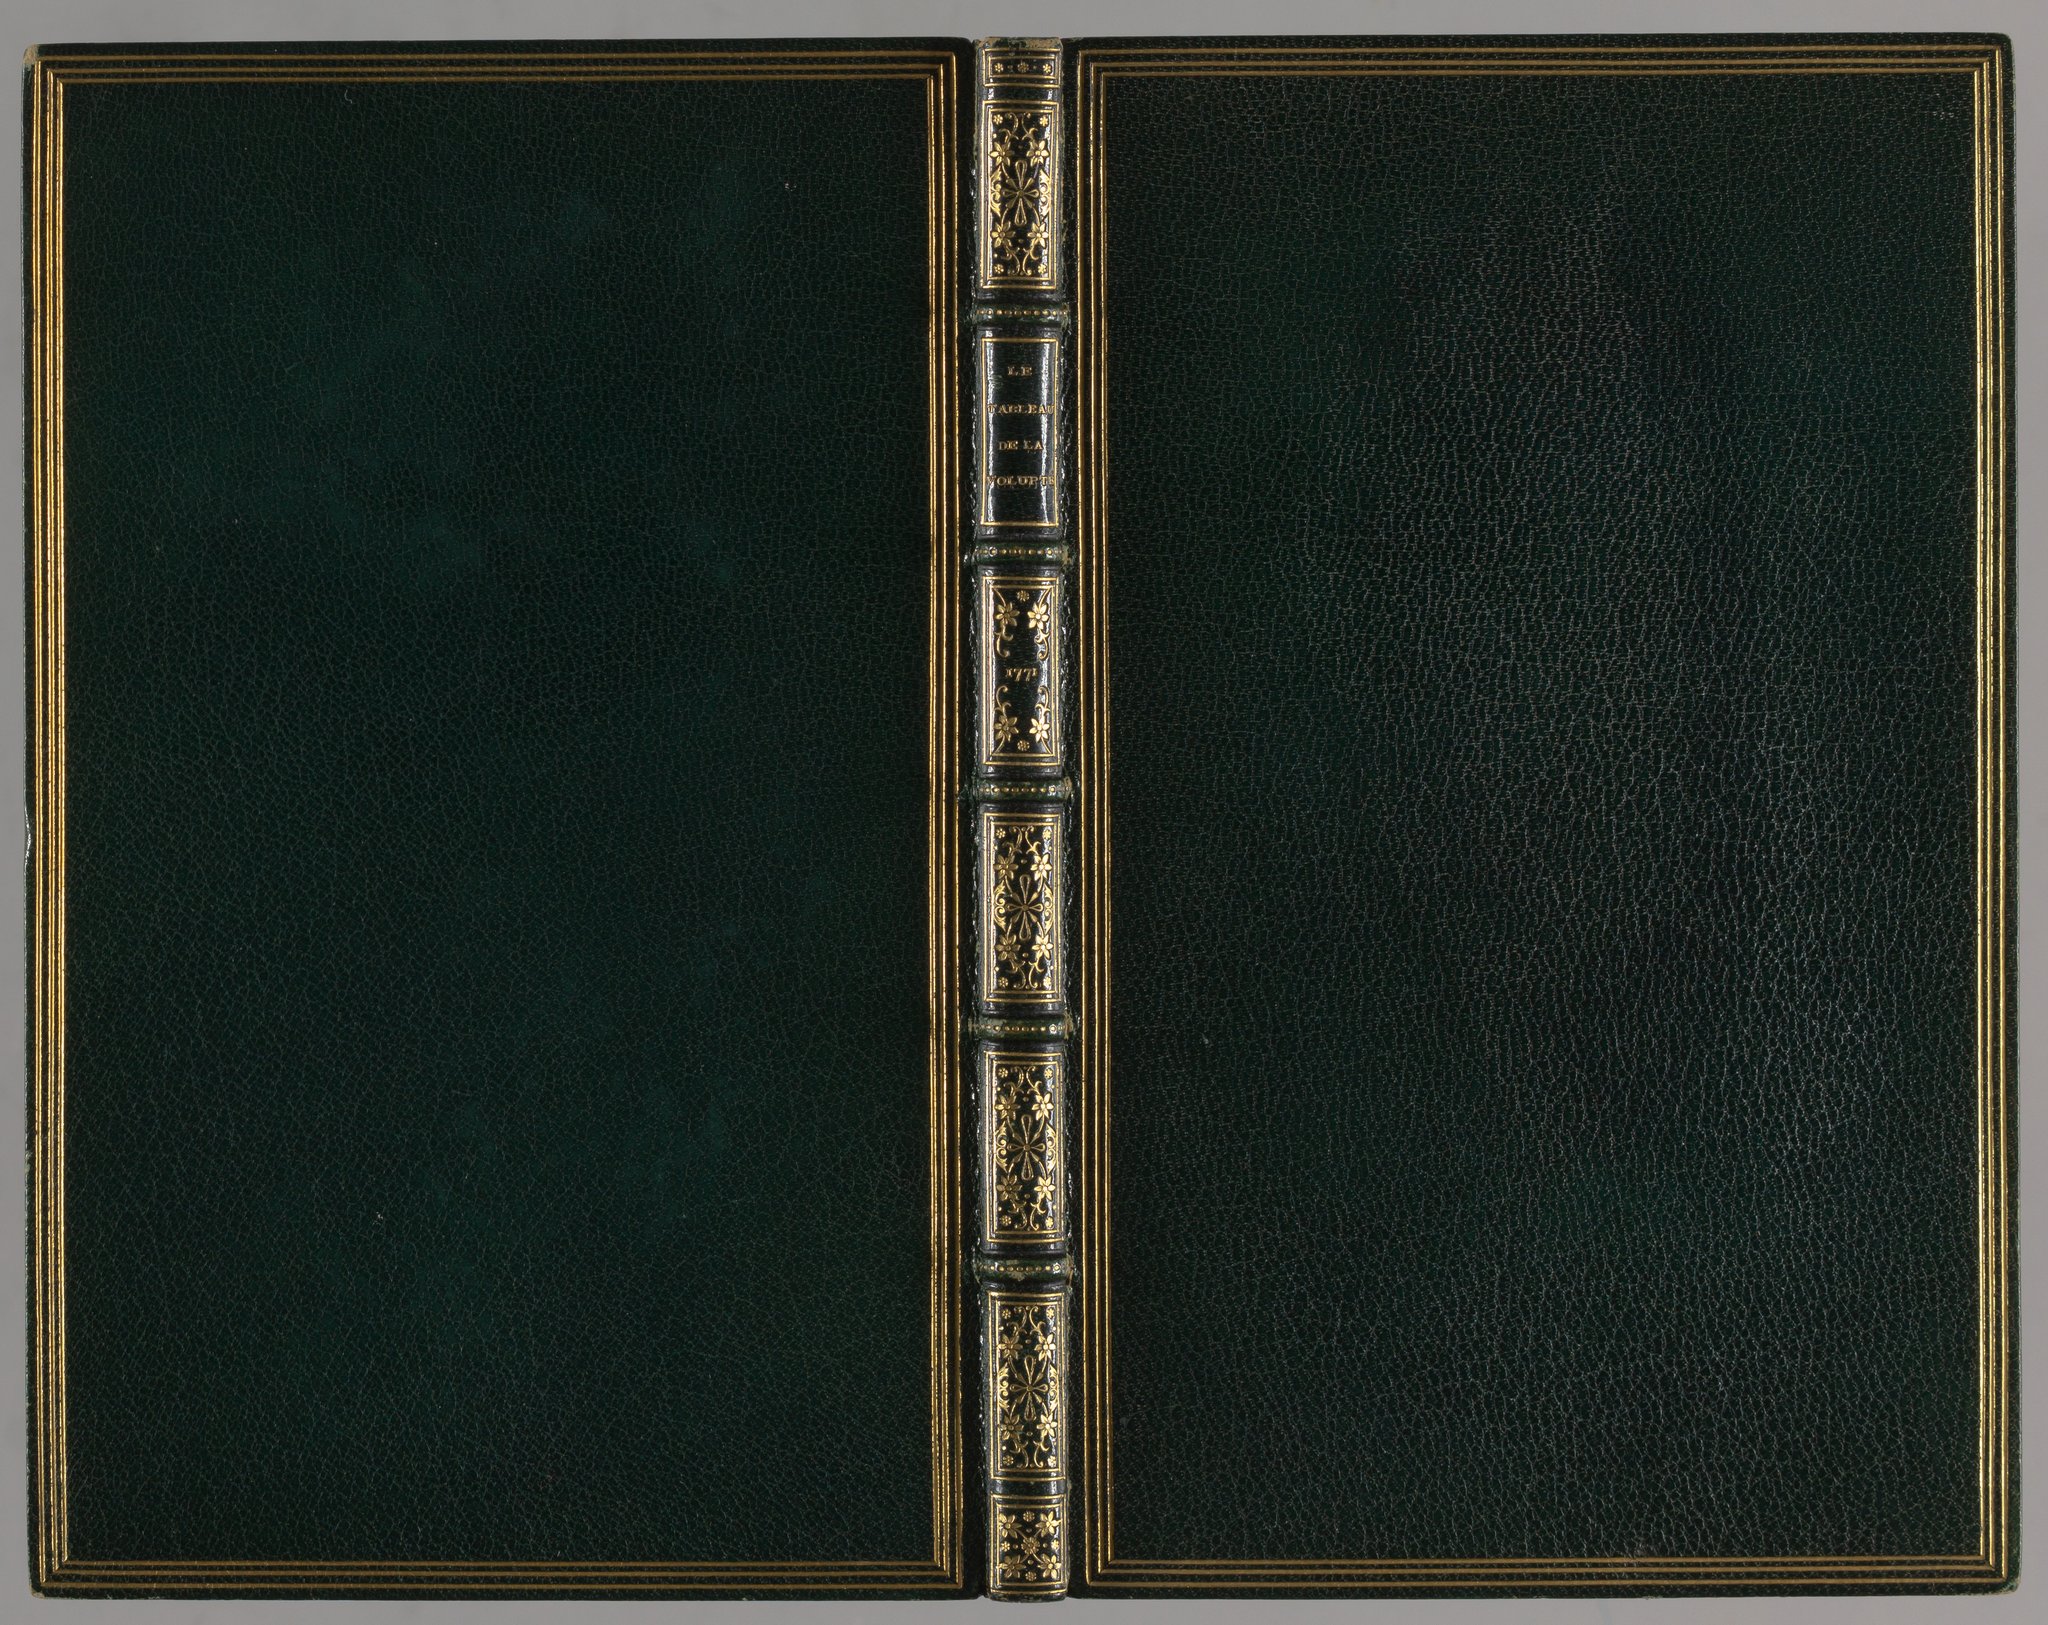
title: Le tableau de la volupté, ou, Les quatre parties du jour : poeme en vers libres / par M.D.B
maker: pierre-ulric dubuisson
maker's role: author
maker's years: 1746-1794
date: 1771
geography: france